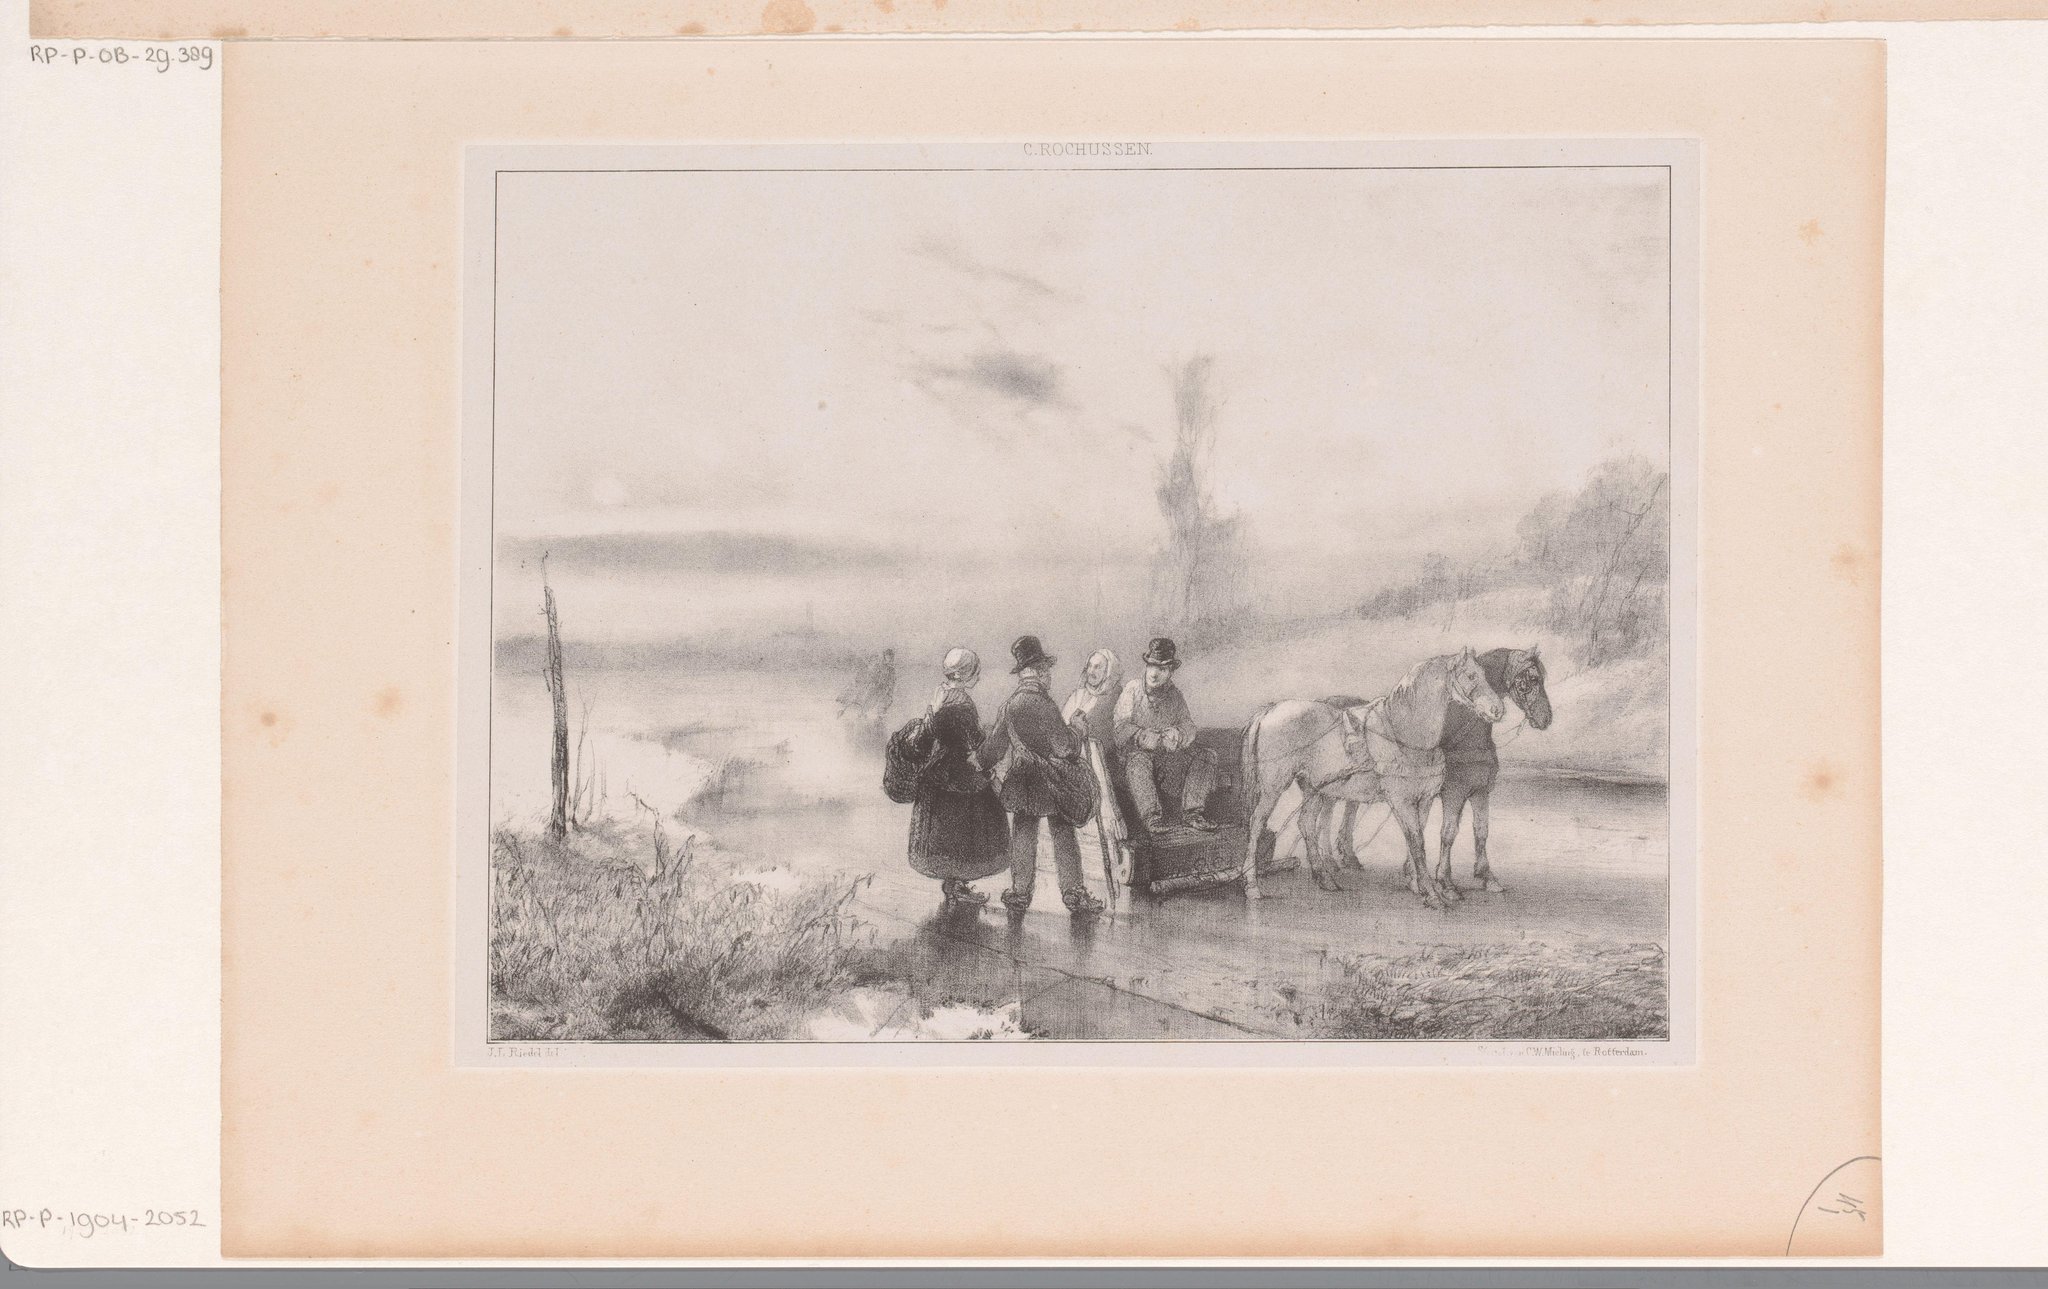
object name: print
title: Ontmoeting op het ijs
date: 1847-1865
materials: paper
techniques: lithograph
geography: rotterdam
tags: frost, freezing weather, horse-sleigh, skates (winter sports), meeting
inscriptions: collector's mark: Lugt 2228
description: Een man en vrouw, gezeten op een slede met twee paarden ervoor, zijn in gesprek met een man en vrouw op schaatsen.